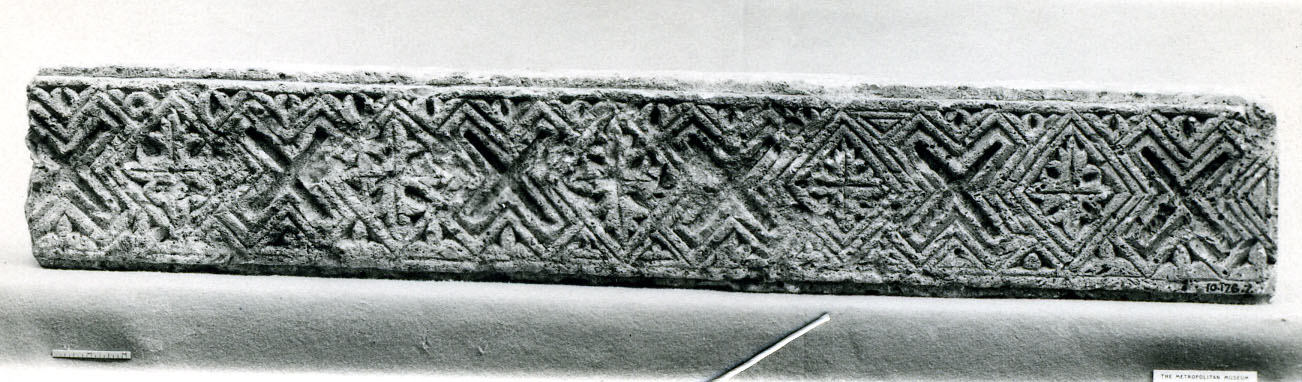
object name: fragment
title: Fragment of a Frieze with a Geometrical Pattern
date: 401-700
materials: limestone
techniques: carving, relief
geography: egypt